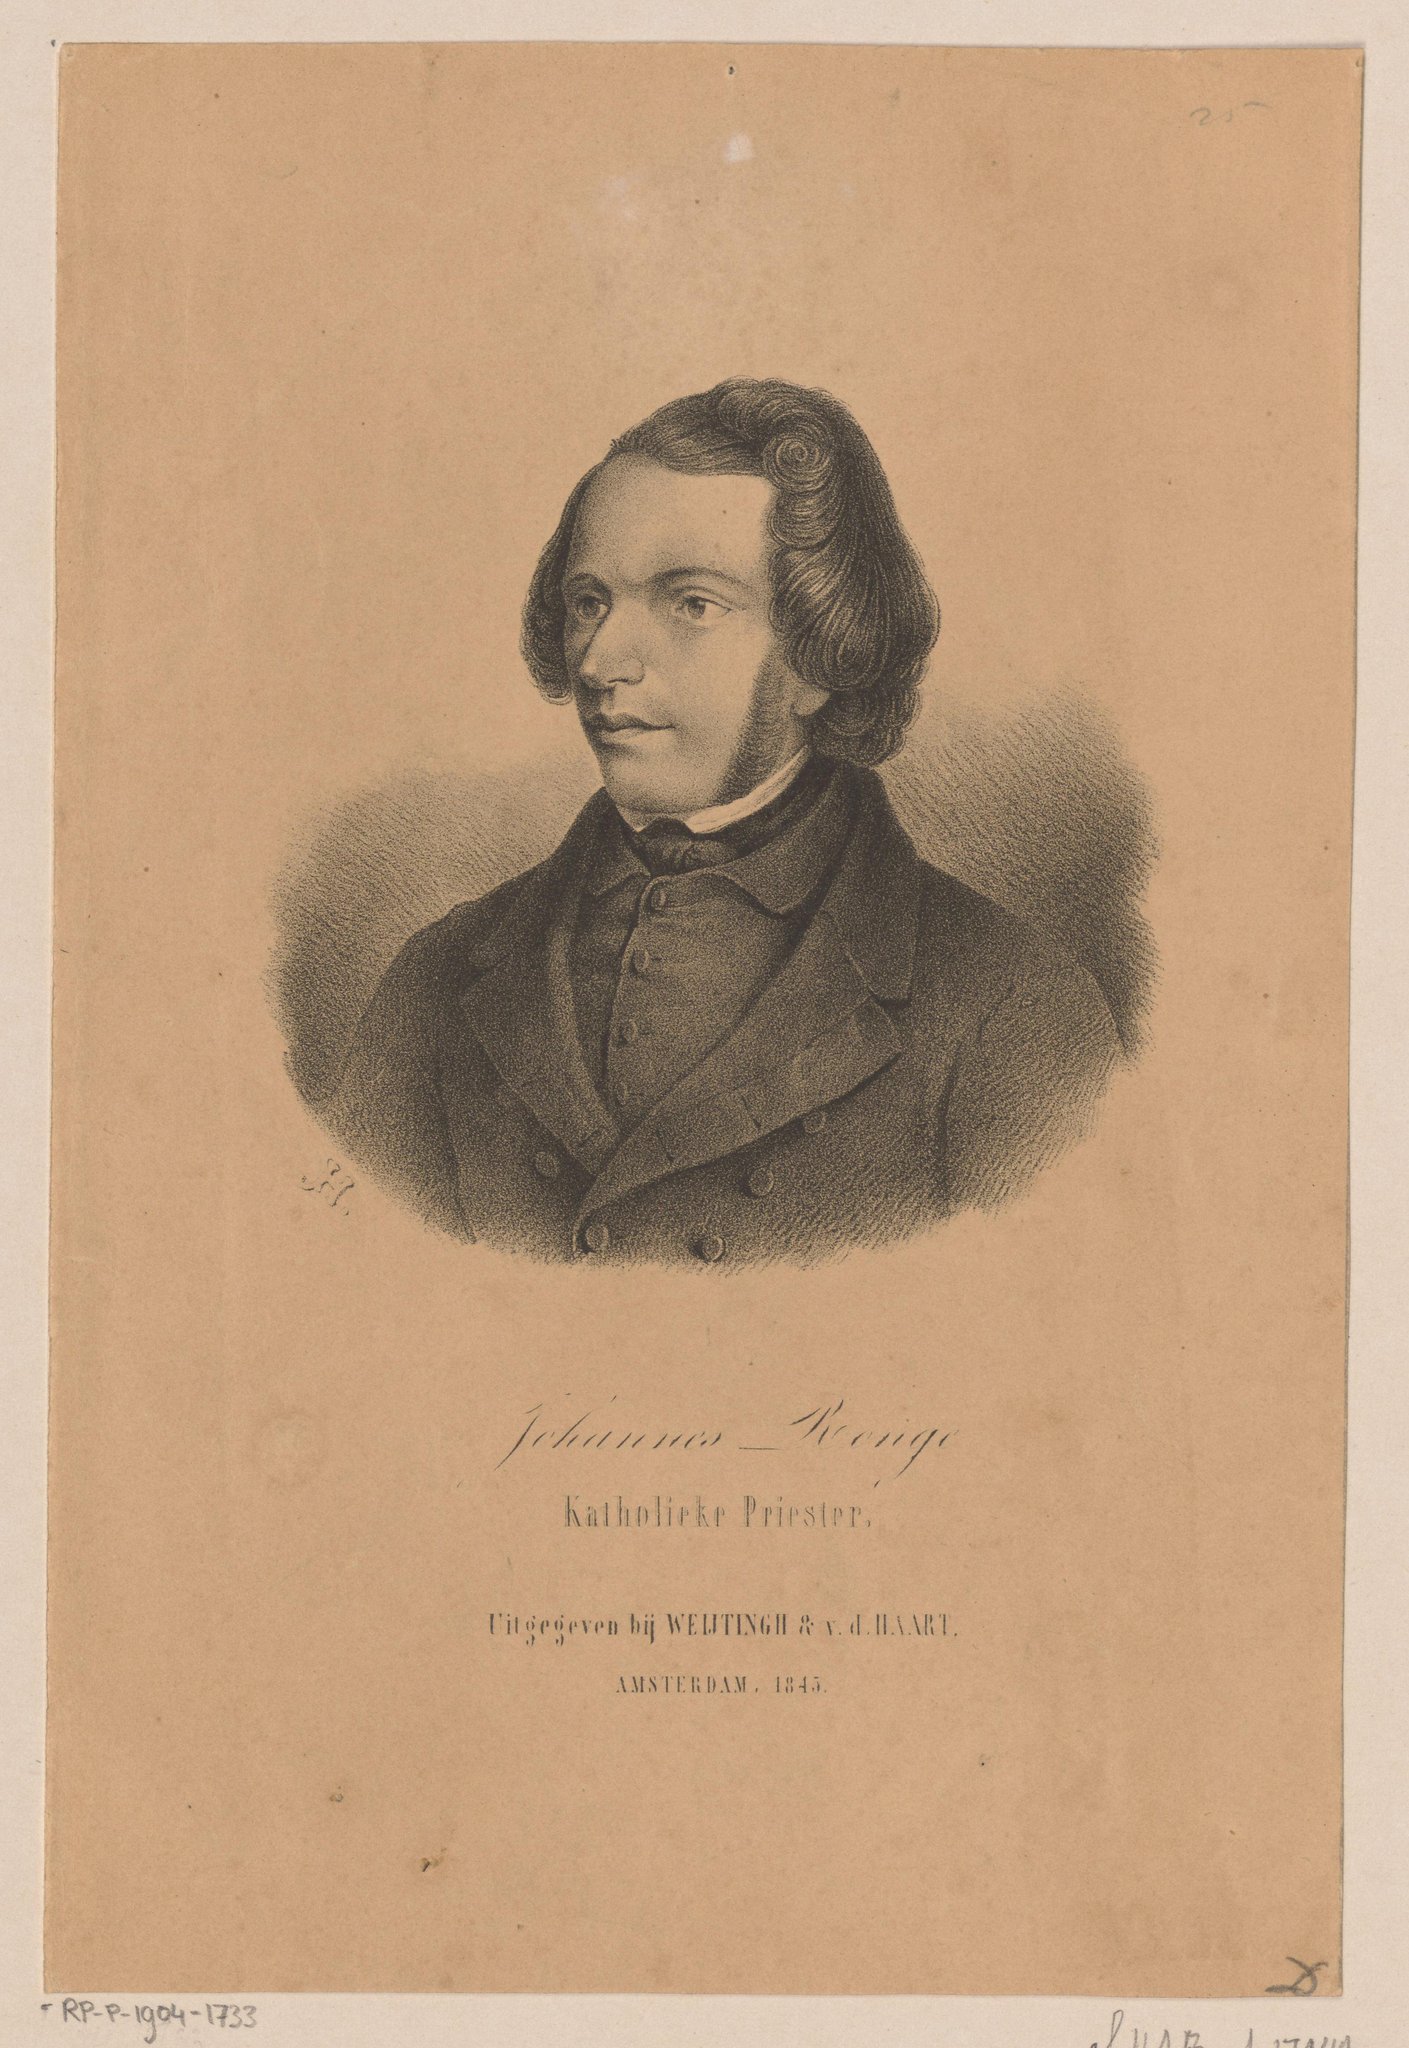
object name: print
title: Portret van Johannes Ronge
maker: johannes hilverdink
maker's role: draughtsman, painter, print maker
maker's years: 1813-1902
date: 1845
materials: paper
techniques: lithograph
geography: amsterdam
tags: vienna, historical persons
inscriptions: collector's mark: Lugt 2228